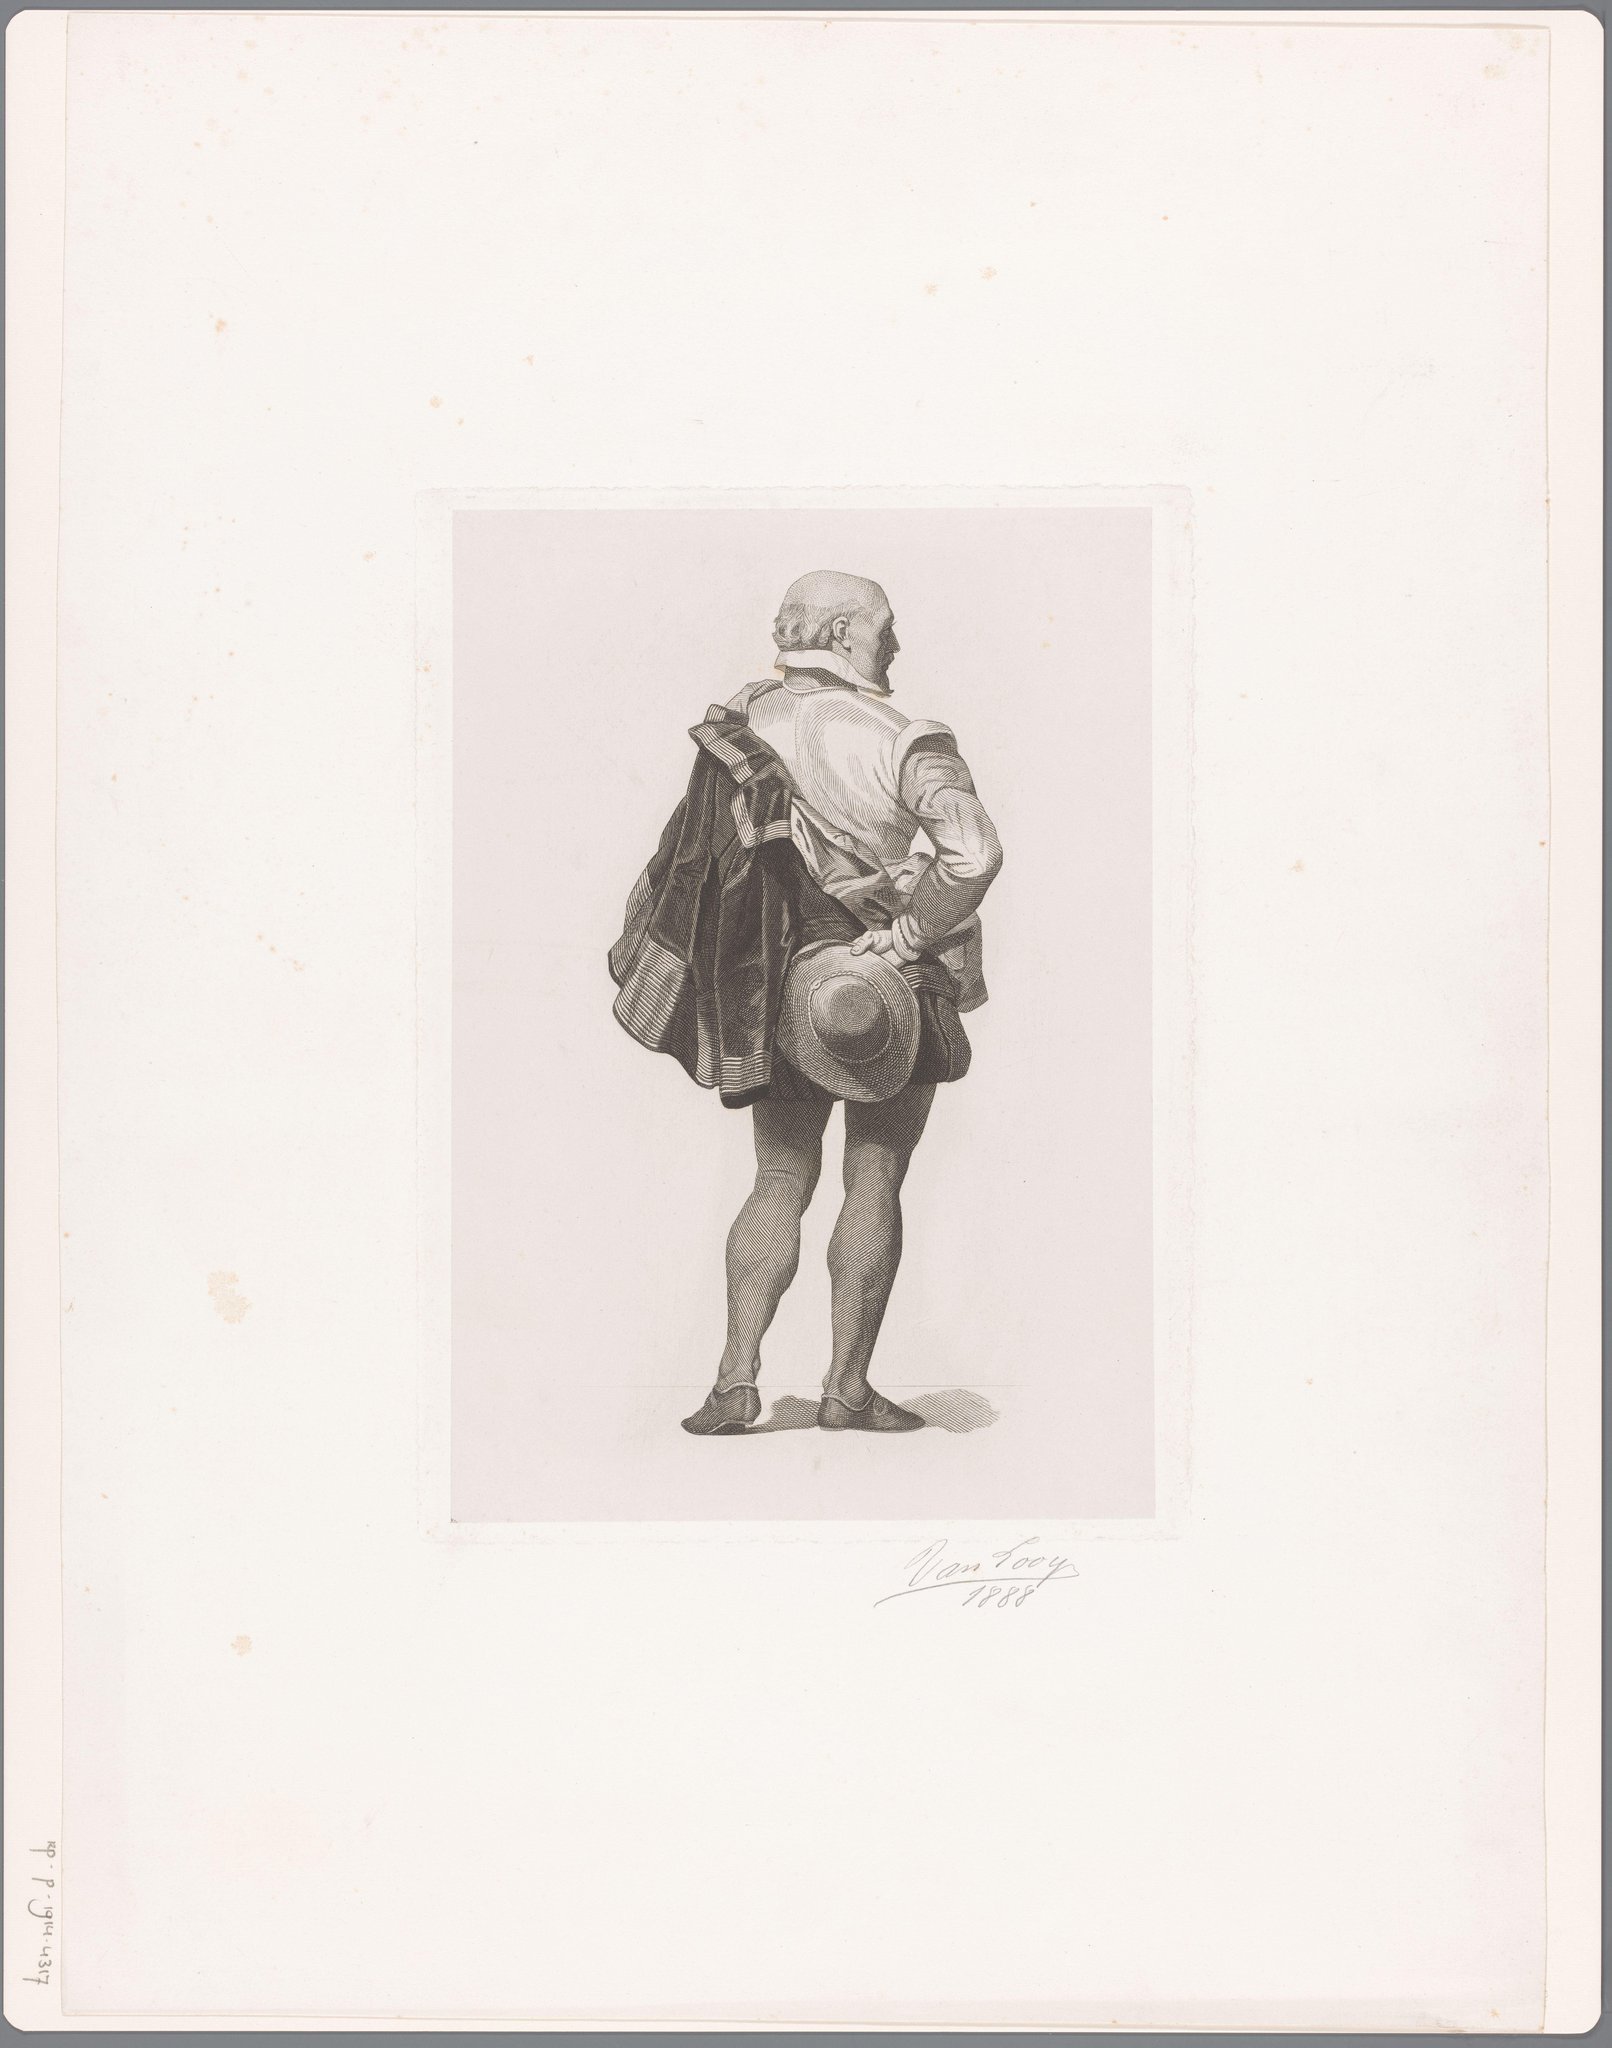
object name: print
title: Man in historische kleding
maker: joseph edouard van looy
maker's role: print maker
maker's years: 1871-1896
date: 1888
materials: paper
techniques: etching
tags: historical costume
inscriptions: collector's mark: Lugt 2228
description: Sterfdatum van de prentmaker is onbekend. Daarom is voor de bepaling van de rechten van dit object gebruik gemaakt van de verwervingsdatum Rijksmuseum Amsterdam.